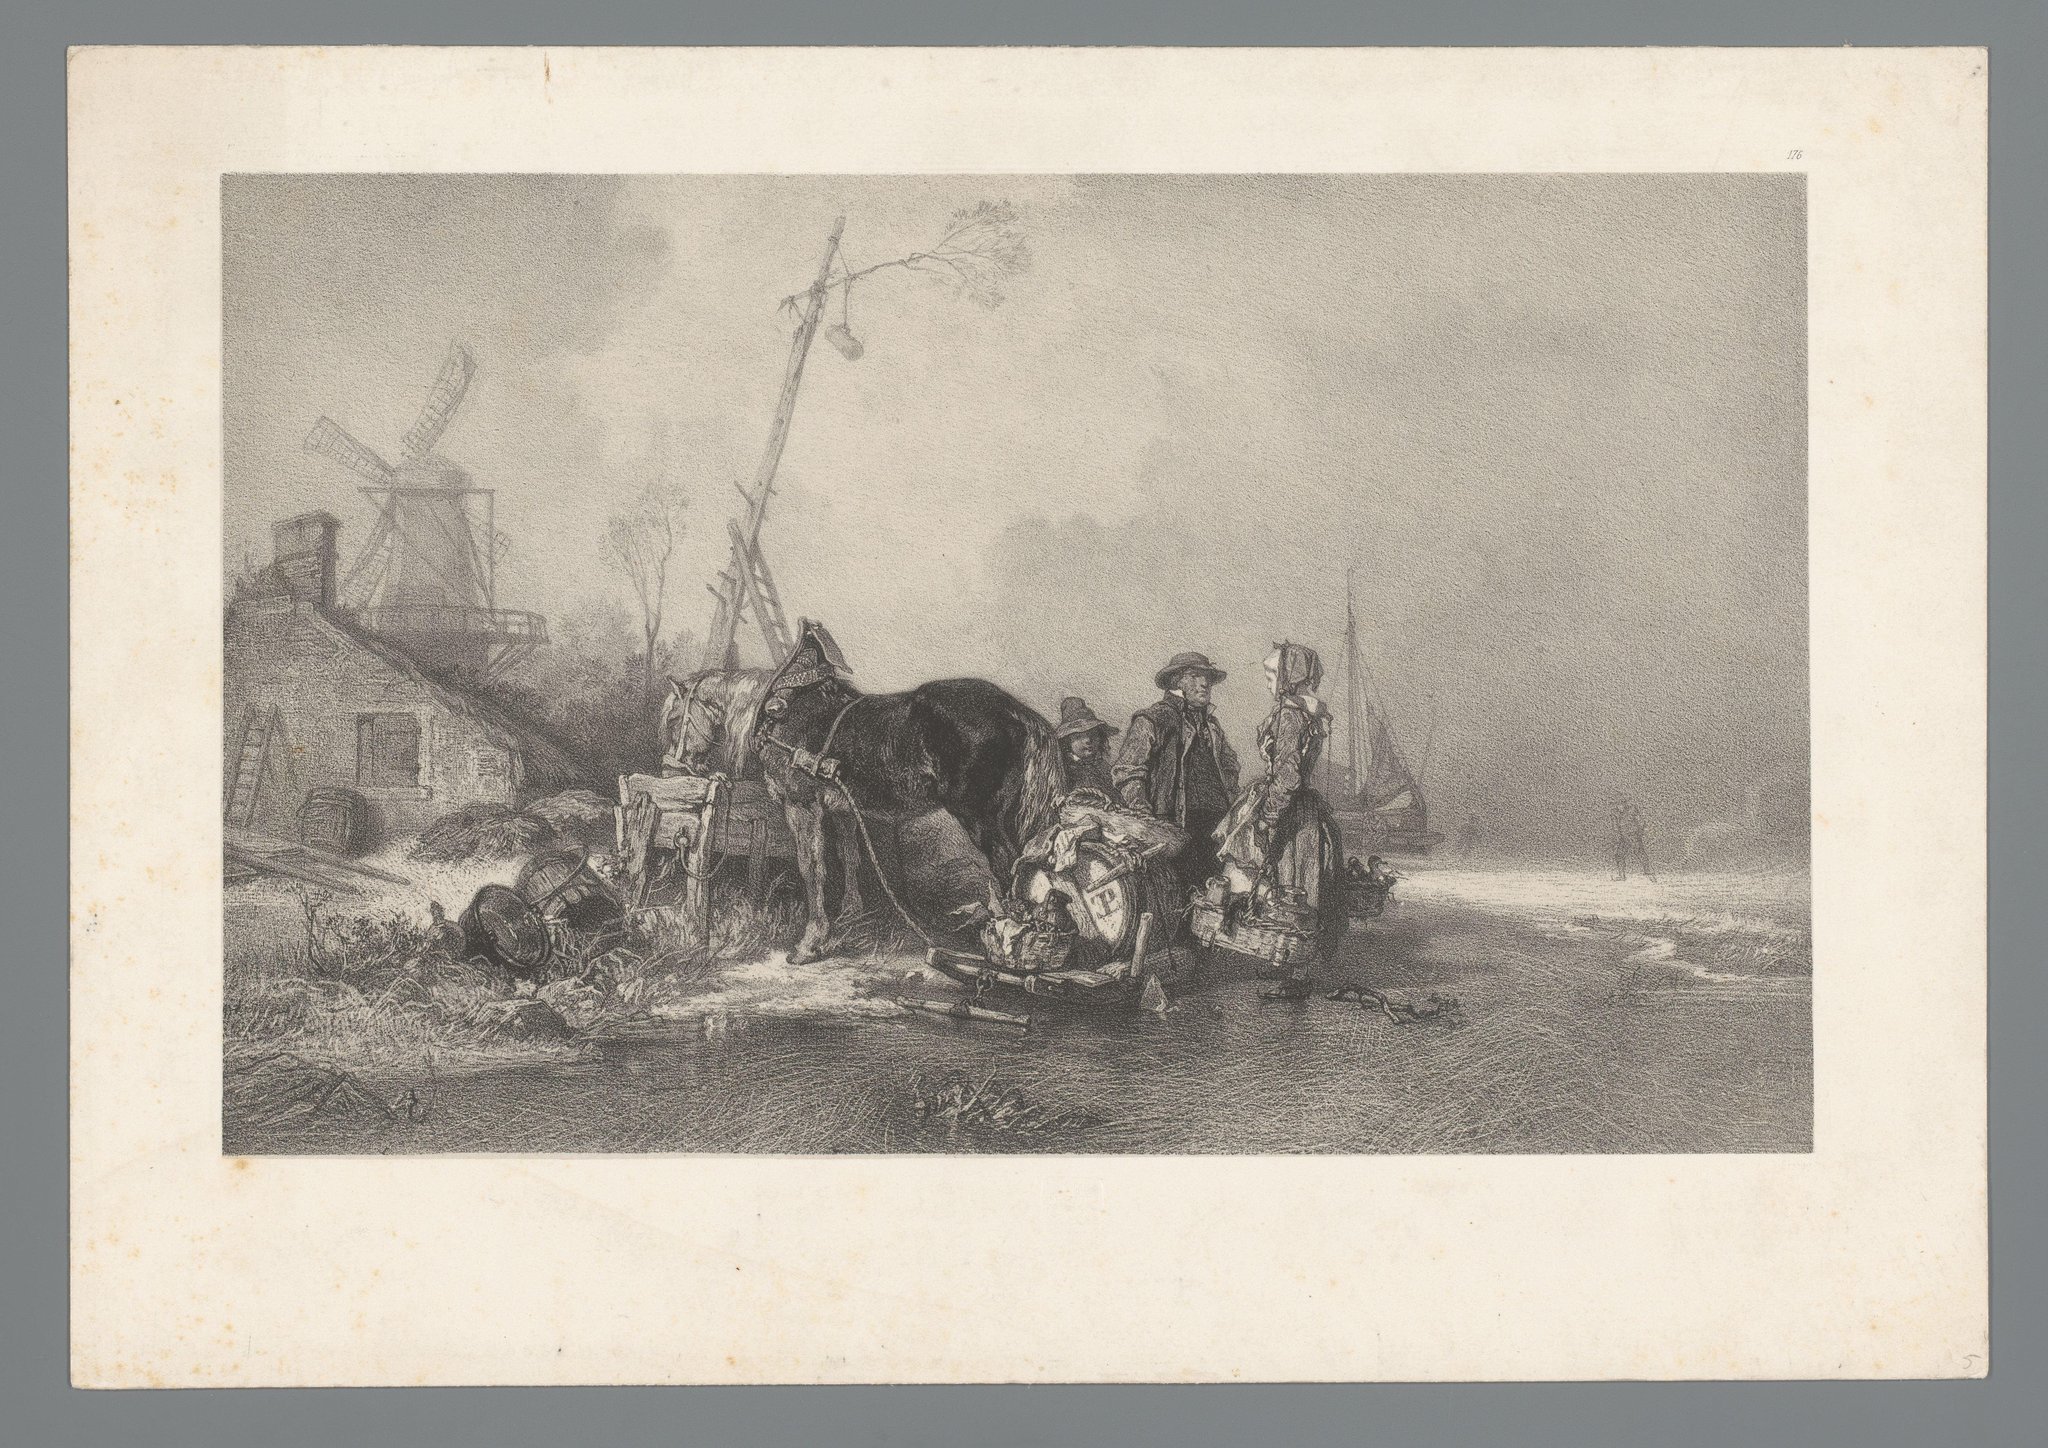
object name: print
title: Eigentijdse kunstenaars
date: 1830-1881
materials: paper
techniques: lithograph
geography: paris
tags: adult woman, sliding (playing with snow and ice) - cc - adult(s) ~ snow and ice, adult man, horse, windmill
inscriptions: check stamp: Lugt 36b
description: Prent verschenen in de serie 'Les artistes contemporains'. Deze serie had volgens Lugt (36b) 175 prenten en werd daarna vervolgd met zeventien prenten die 1-17 zijn genummerd. Mogelijk is deze proedruk met nummer 176 één van die zeventien prenten en is deze later anders genummerd.